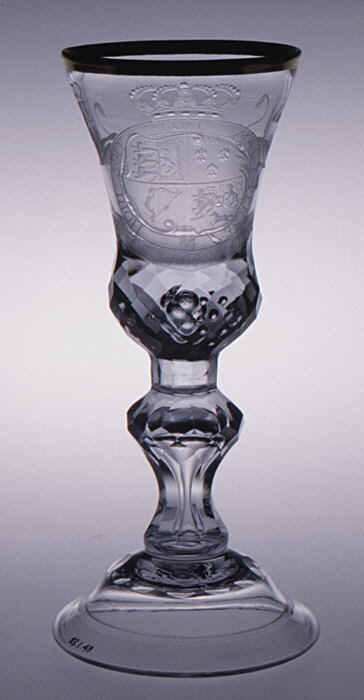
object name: drinking glass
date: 1714-1760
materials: glass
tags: coat of arms